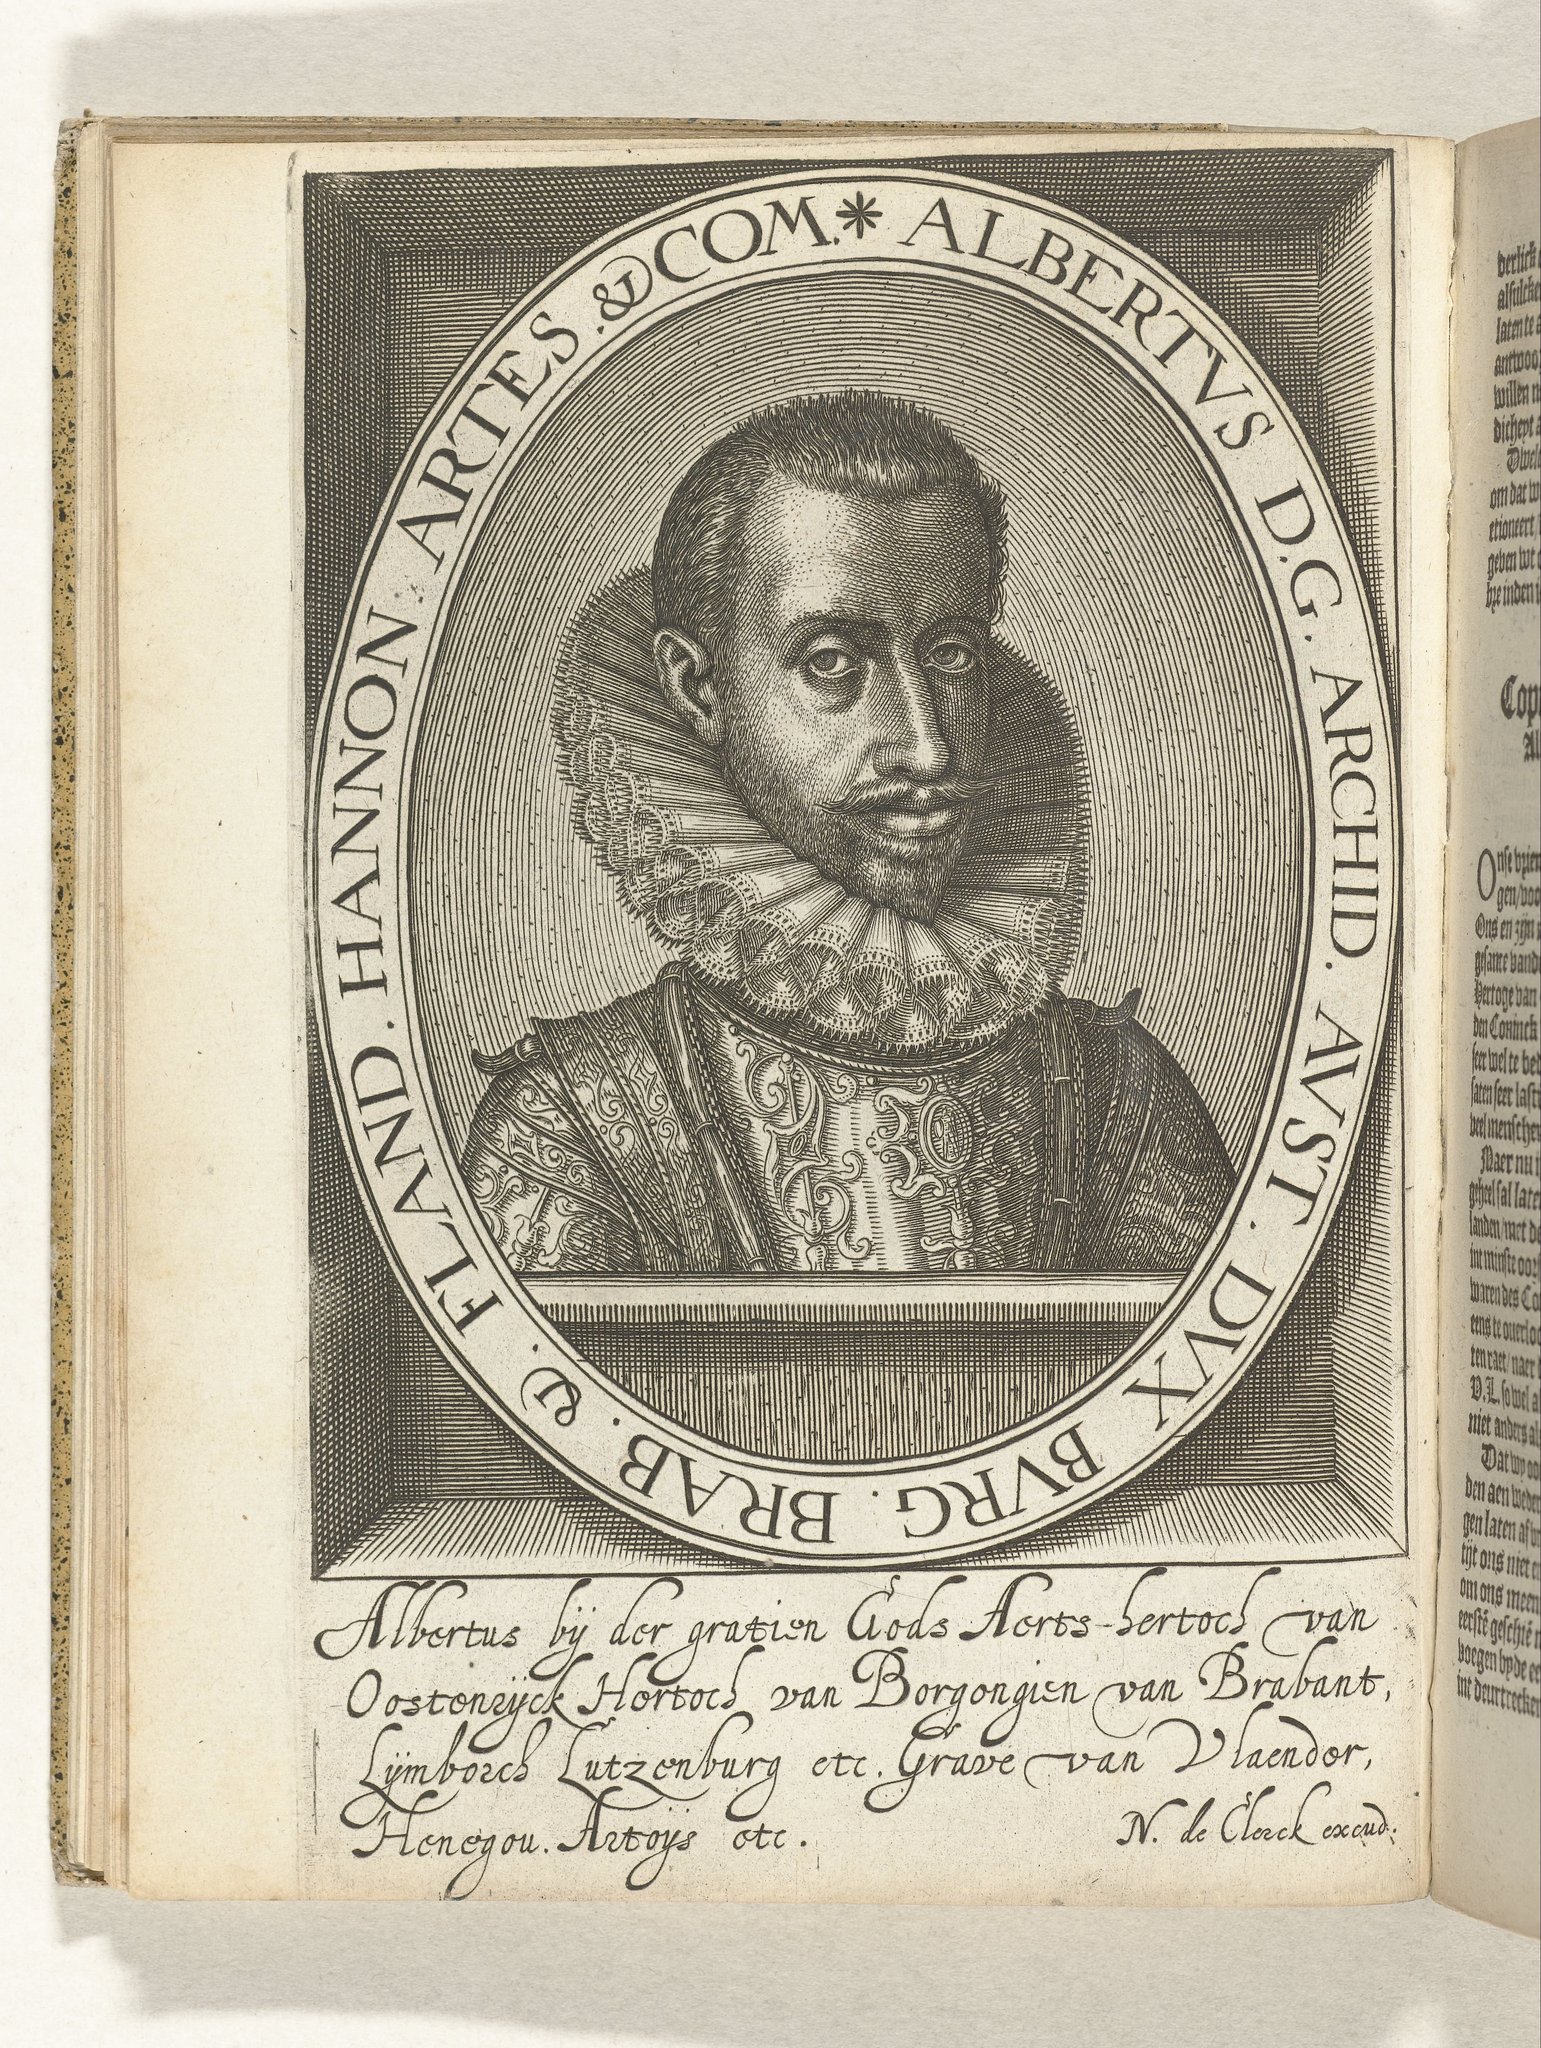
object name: pamphlet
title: Portret van aartshertog Albrecht, 1599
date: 1590-1599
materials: paper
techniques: engraving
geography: low countries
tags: brussels, albrecht aartshertog van oostenrijk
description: Portret van aartshertog Albrecht van Oostenrijk, 1599. Ovaal portret met borstbeeld van de aartshertog, met randschrift in het Latijn en onderschrift van 4 regels in het Nederlands. Opgenomen in het pamflet getiteld: Den Spaenschen ende Arragoenschen spiegel. Inde welcke men mach claerlick ende waerachtich sien tot wat eynde ... het voornemen is ... van 't Spaensche Crijchsvolck, dat hem desen Winter heeft gehouden in den Westphaelschen Creyts.